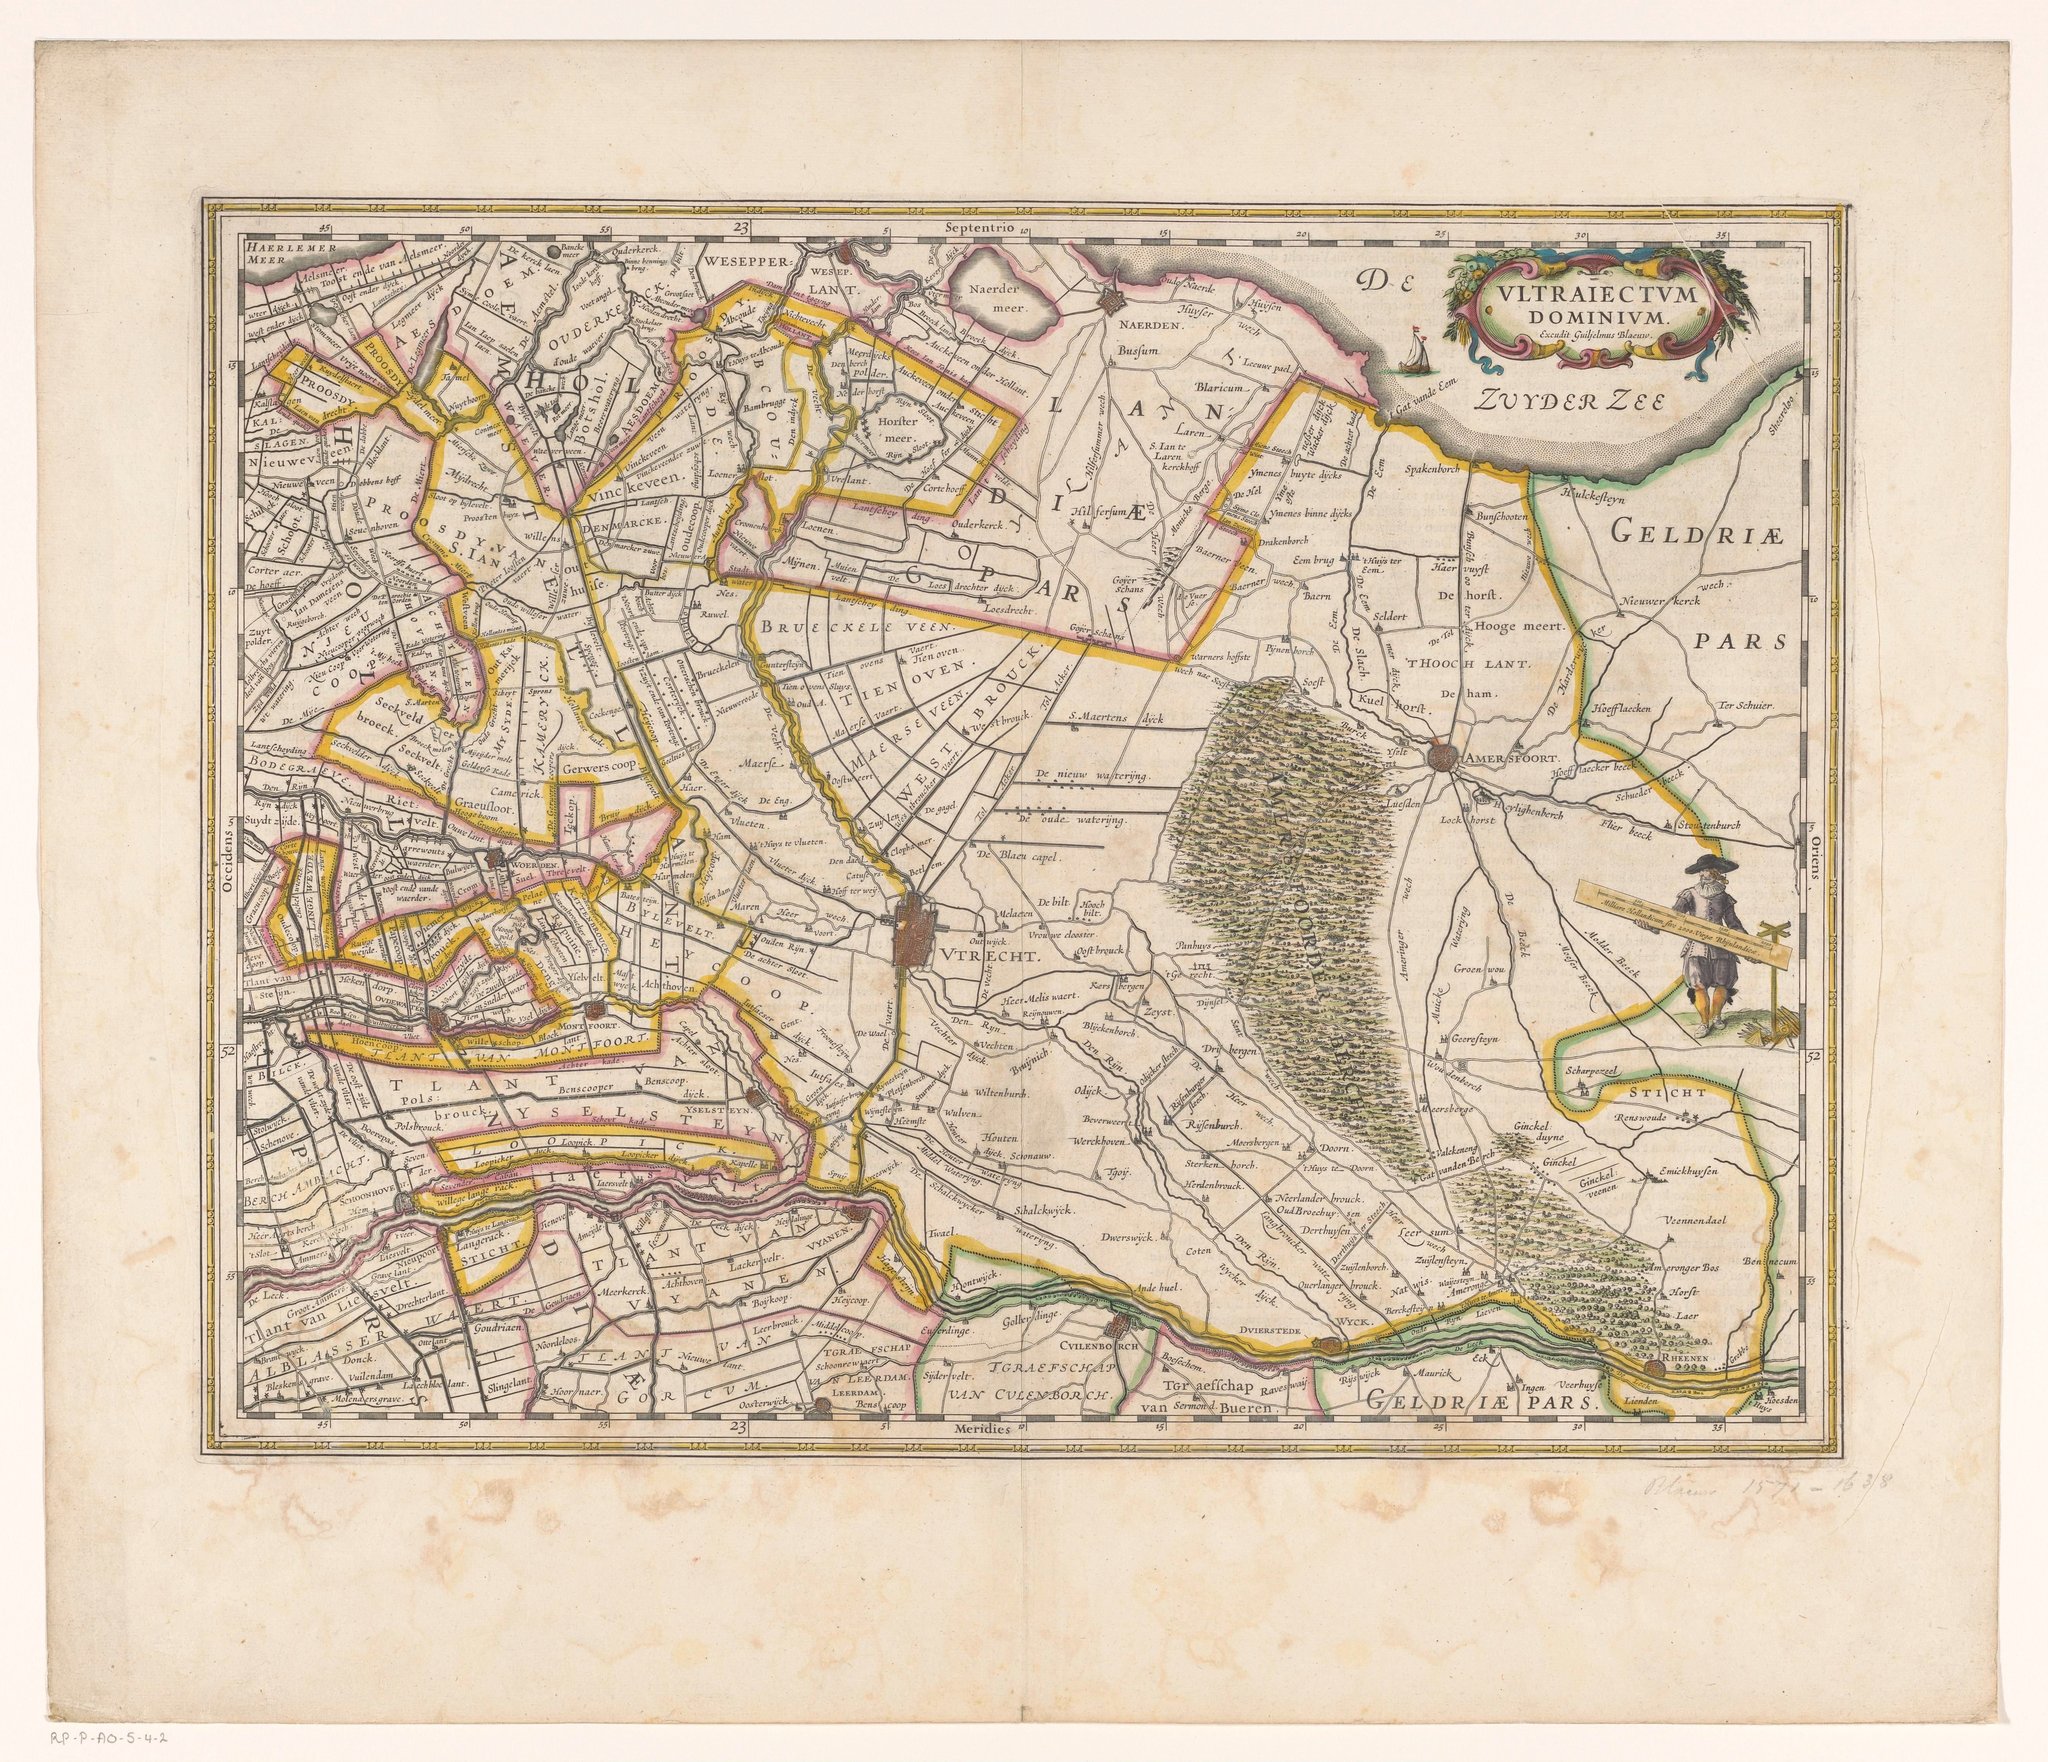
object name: print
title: Ultraiectum dominium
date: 1630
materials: paper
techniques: engraving, etching, hand coloring, letterpress printing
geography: amsterdam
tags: maps of separate countries or regions, geodesy, surveying, folk costume, regional costume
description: Rechtsboven de titelcartouche, rechts in het midden een man met meetapparatuur naast zich en een schaalstok in zijn handen: Milliare Hollandicum sive 2000 virgae Rhijnlandicae. Gradenverdeling langs de randen. Op verso Nederlandse tekst.